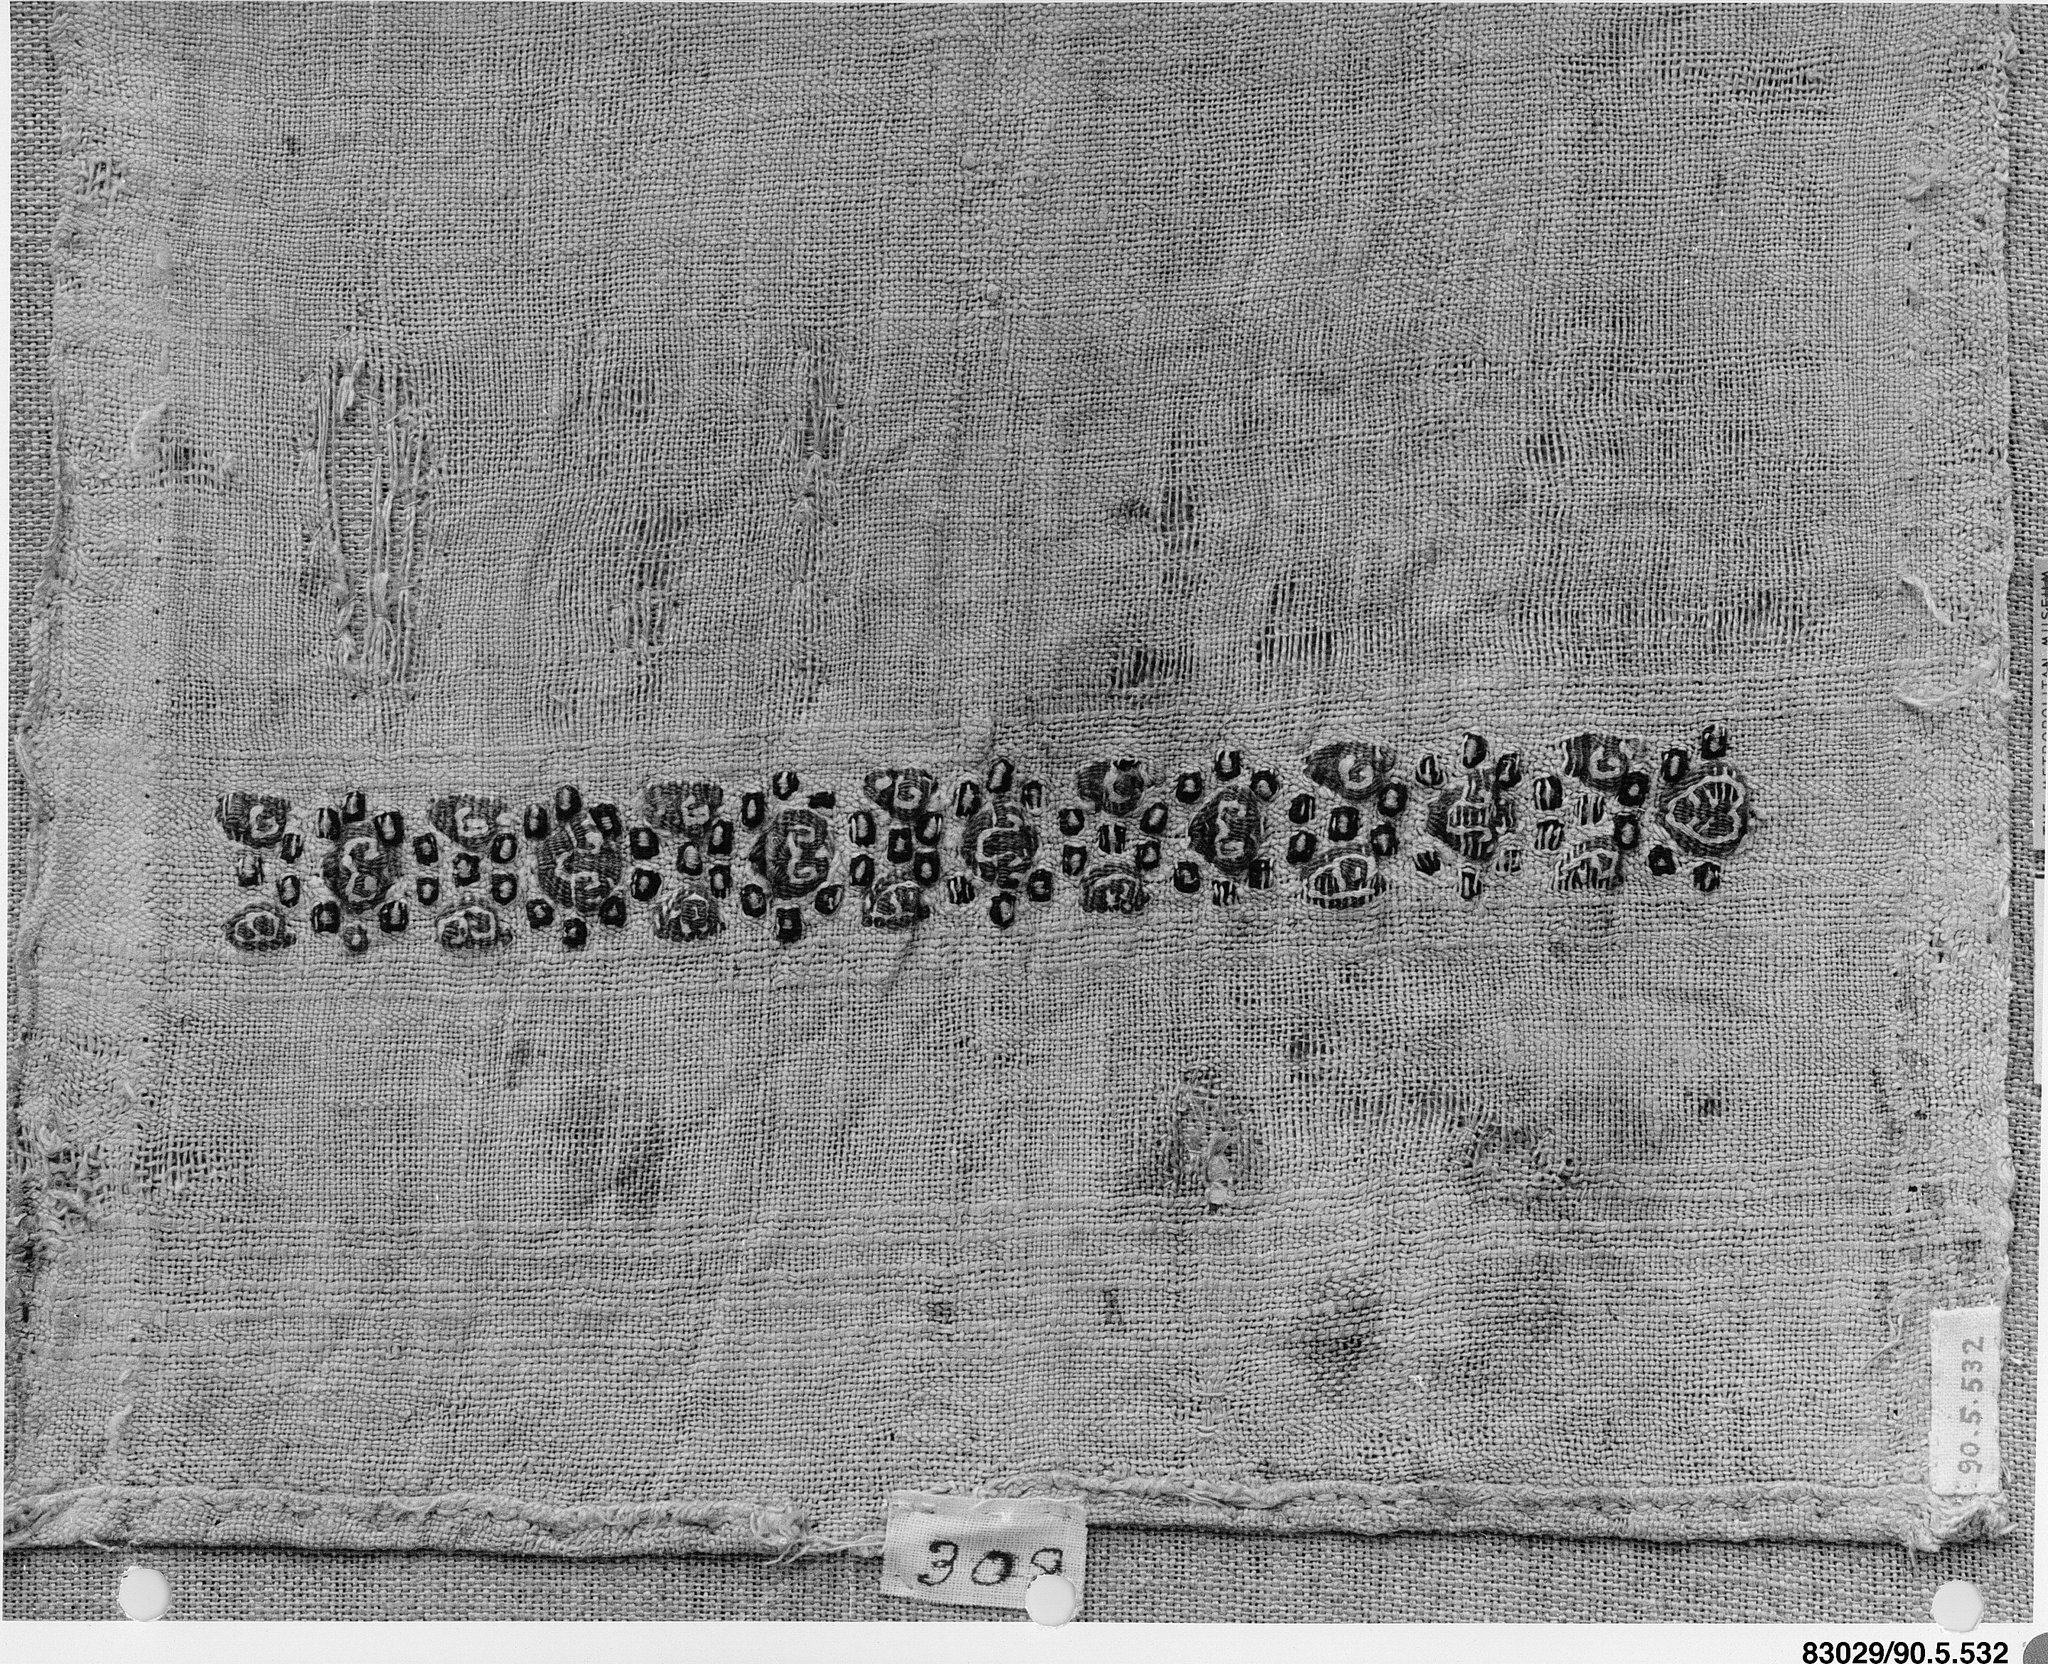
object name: textile fragment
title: Fragment of a Sleeve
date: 401-500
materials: linen, wool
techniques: weave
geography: egypt